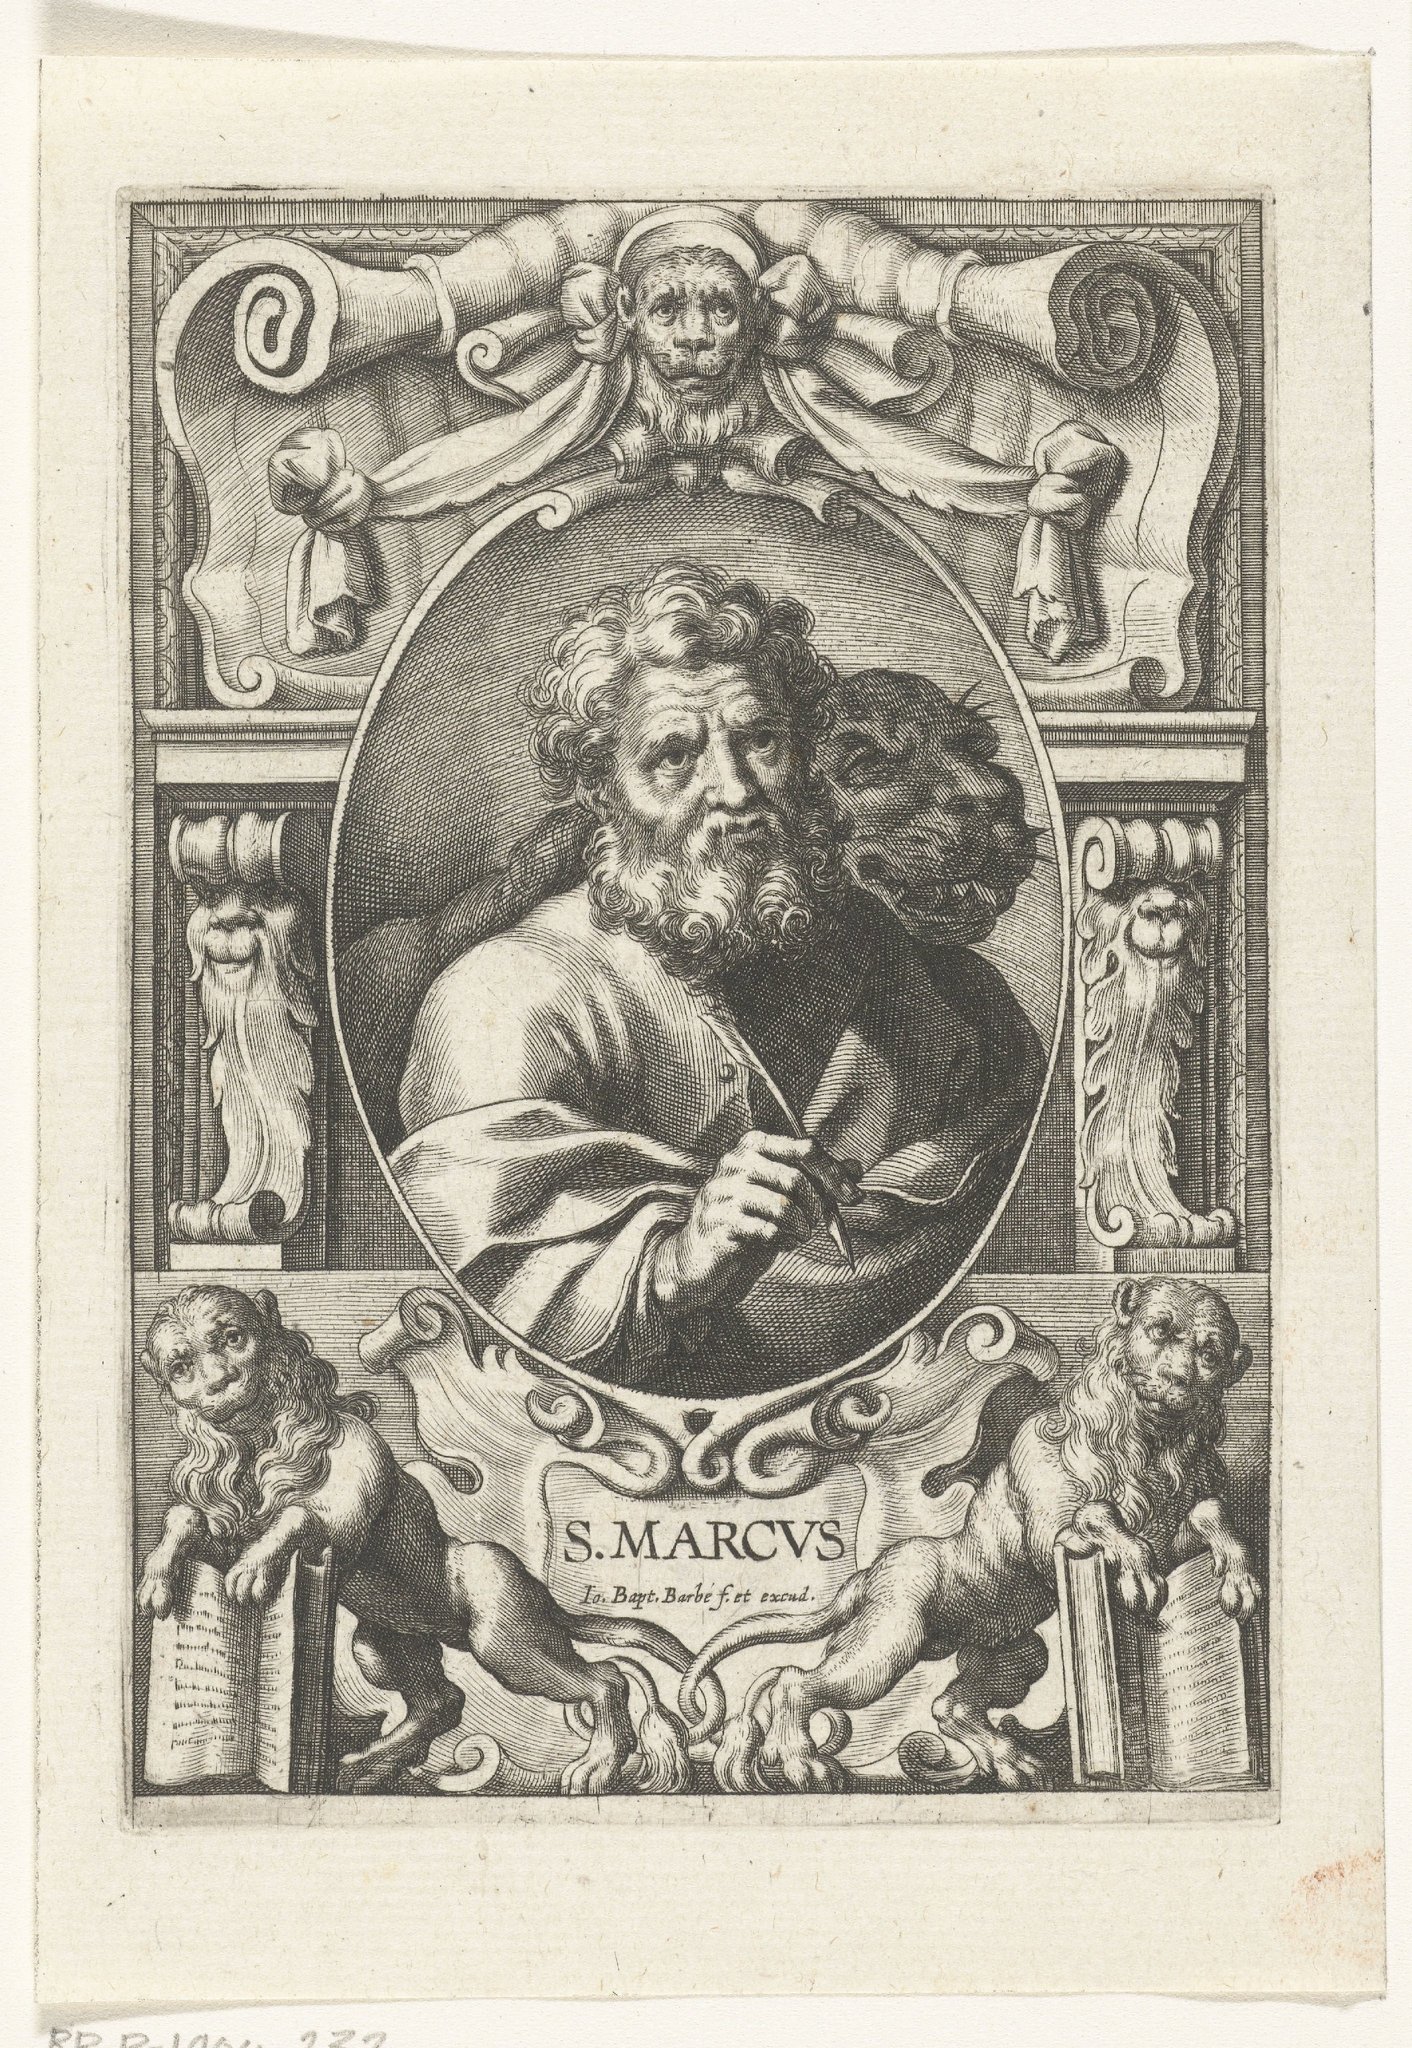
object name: print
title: SS. Apostolorum et Evangelistorum Icones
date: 1588-1648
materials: paper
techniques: engraving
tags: mark (marcus) the evangelist, and bishop of alexandria; possible attributes: book, (winged) lion, pen and inkhorn, scroll, ornament derived from architectural details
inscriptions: collector's mark: Lugt 2228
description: Prent uit: SS. Apostolorum et Evangelistorum Icones, Jean Baptiste Barbé (uitgever). Prent naar tekening van Nicolaas van der Horst.